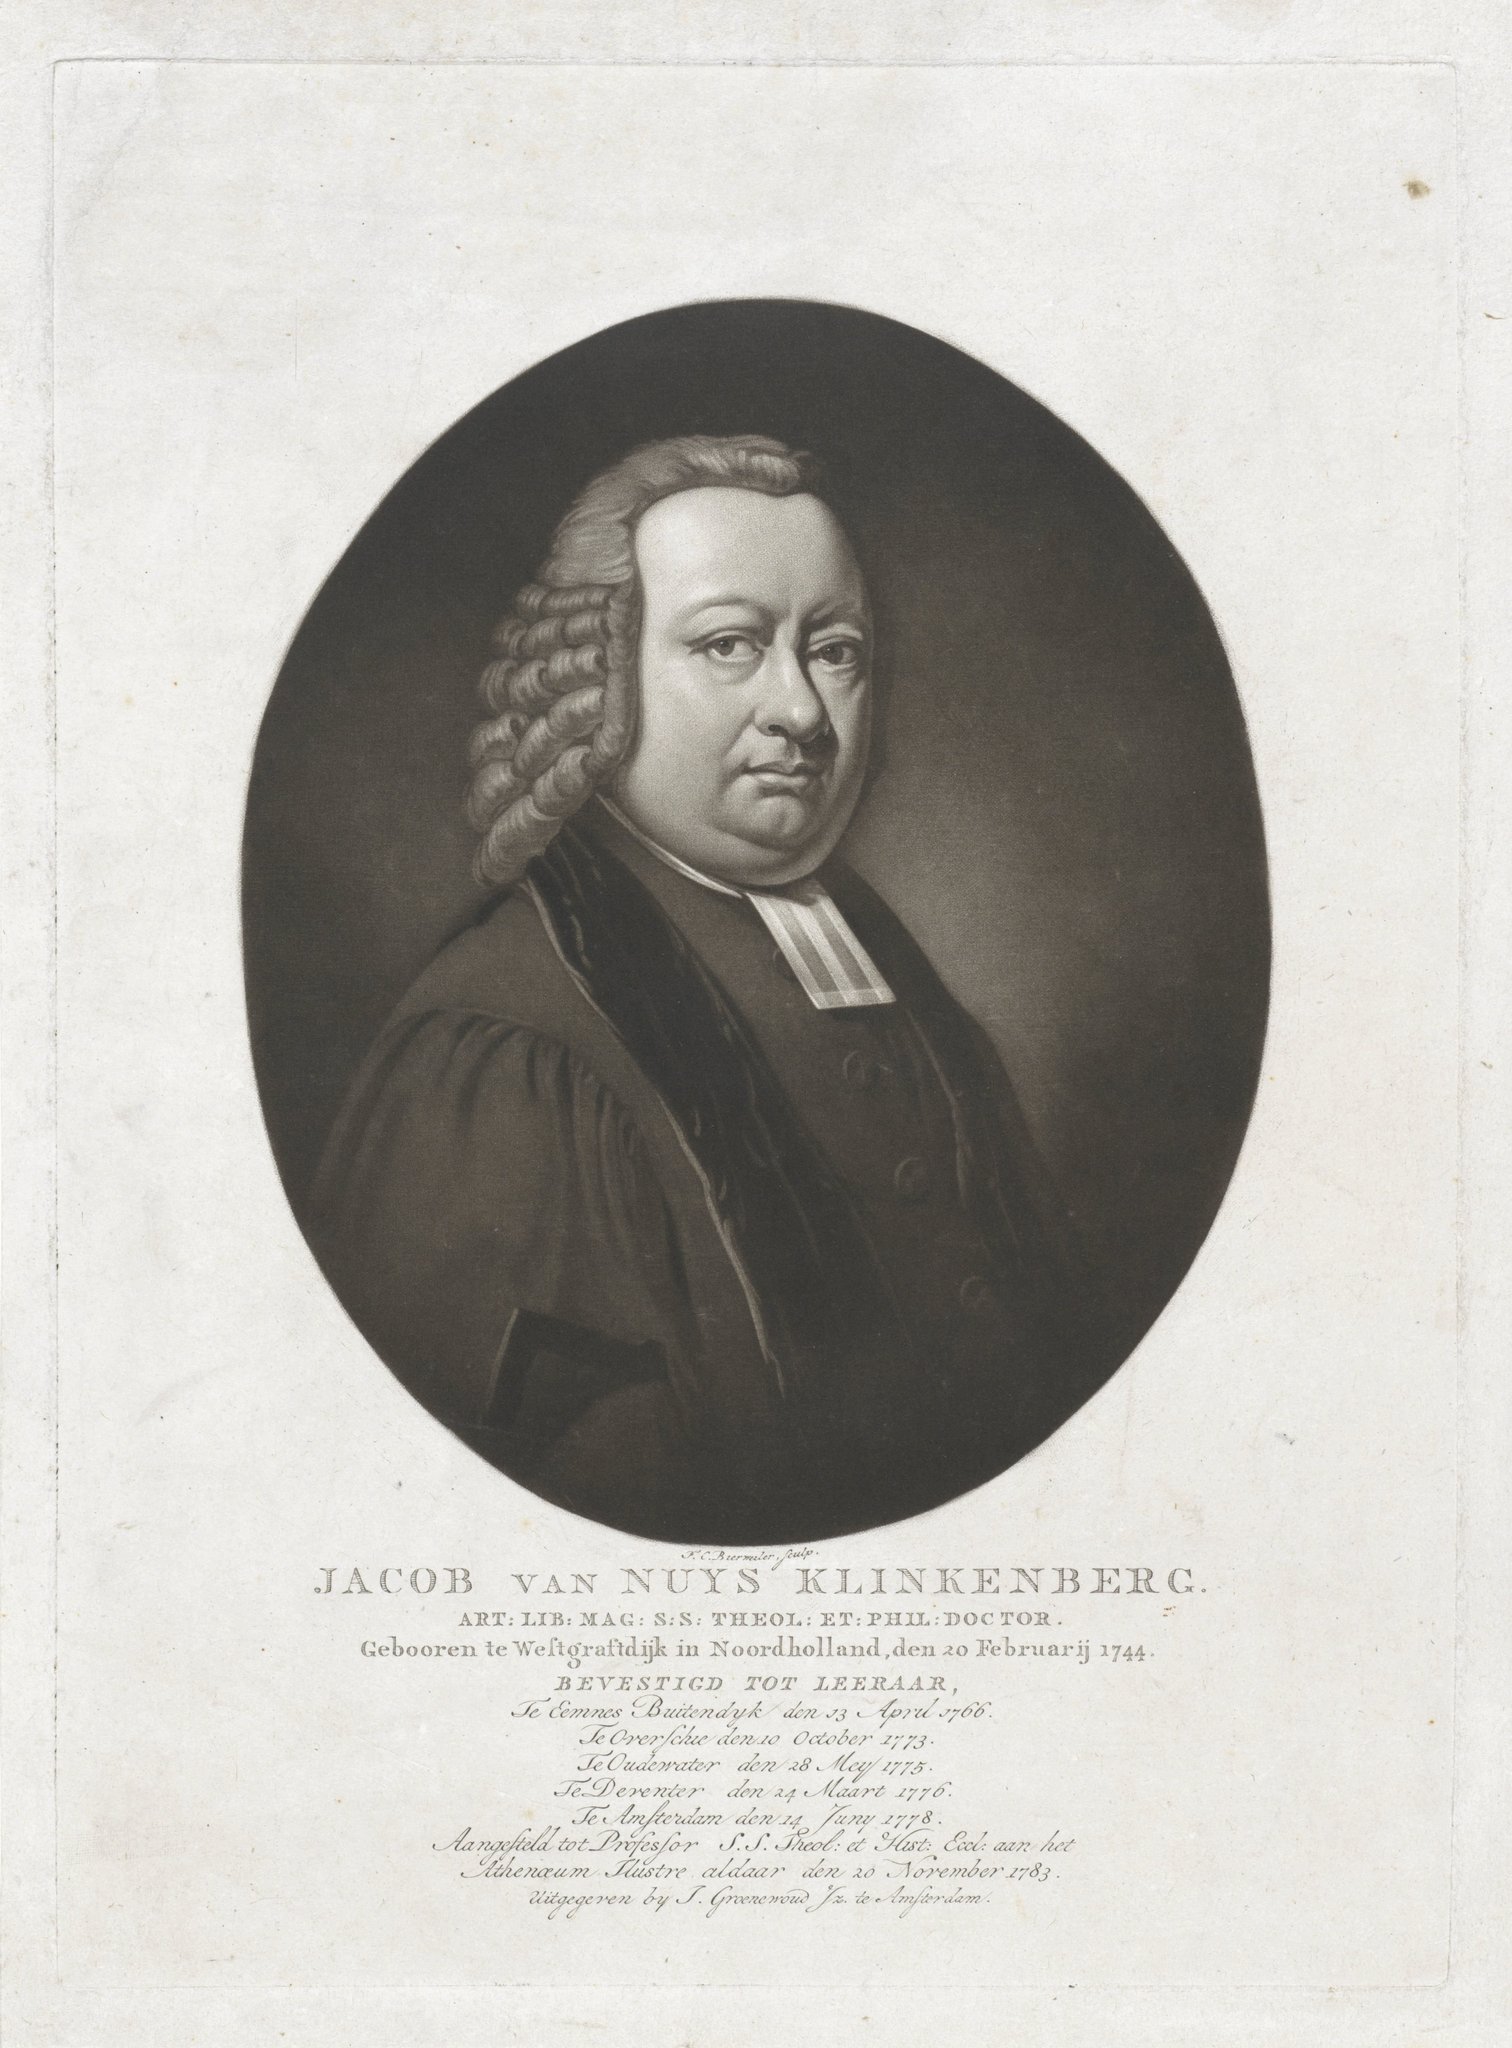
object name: print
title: Portret van Jacob van Nuys Klinkenberg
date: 1793-1817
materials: paper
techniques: engraving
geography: amsterdam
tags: wig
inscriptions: collector's mark: Lugt 2228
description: Portret van Jacob van Nuys Klinkenberg, predikant en hoogleraar theologie.